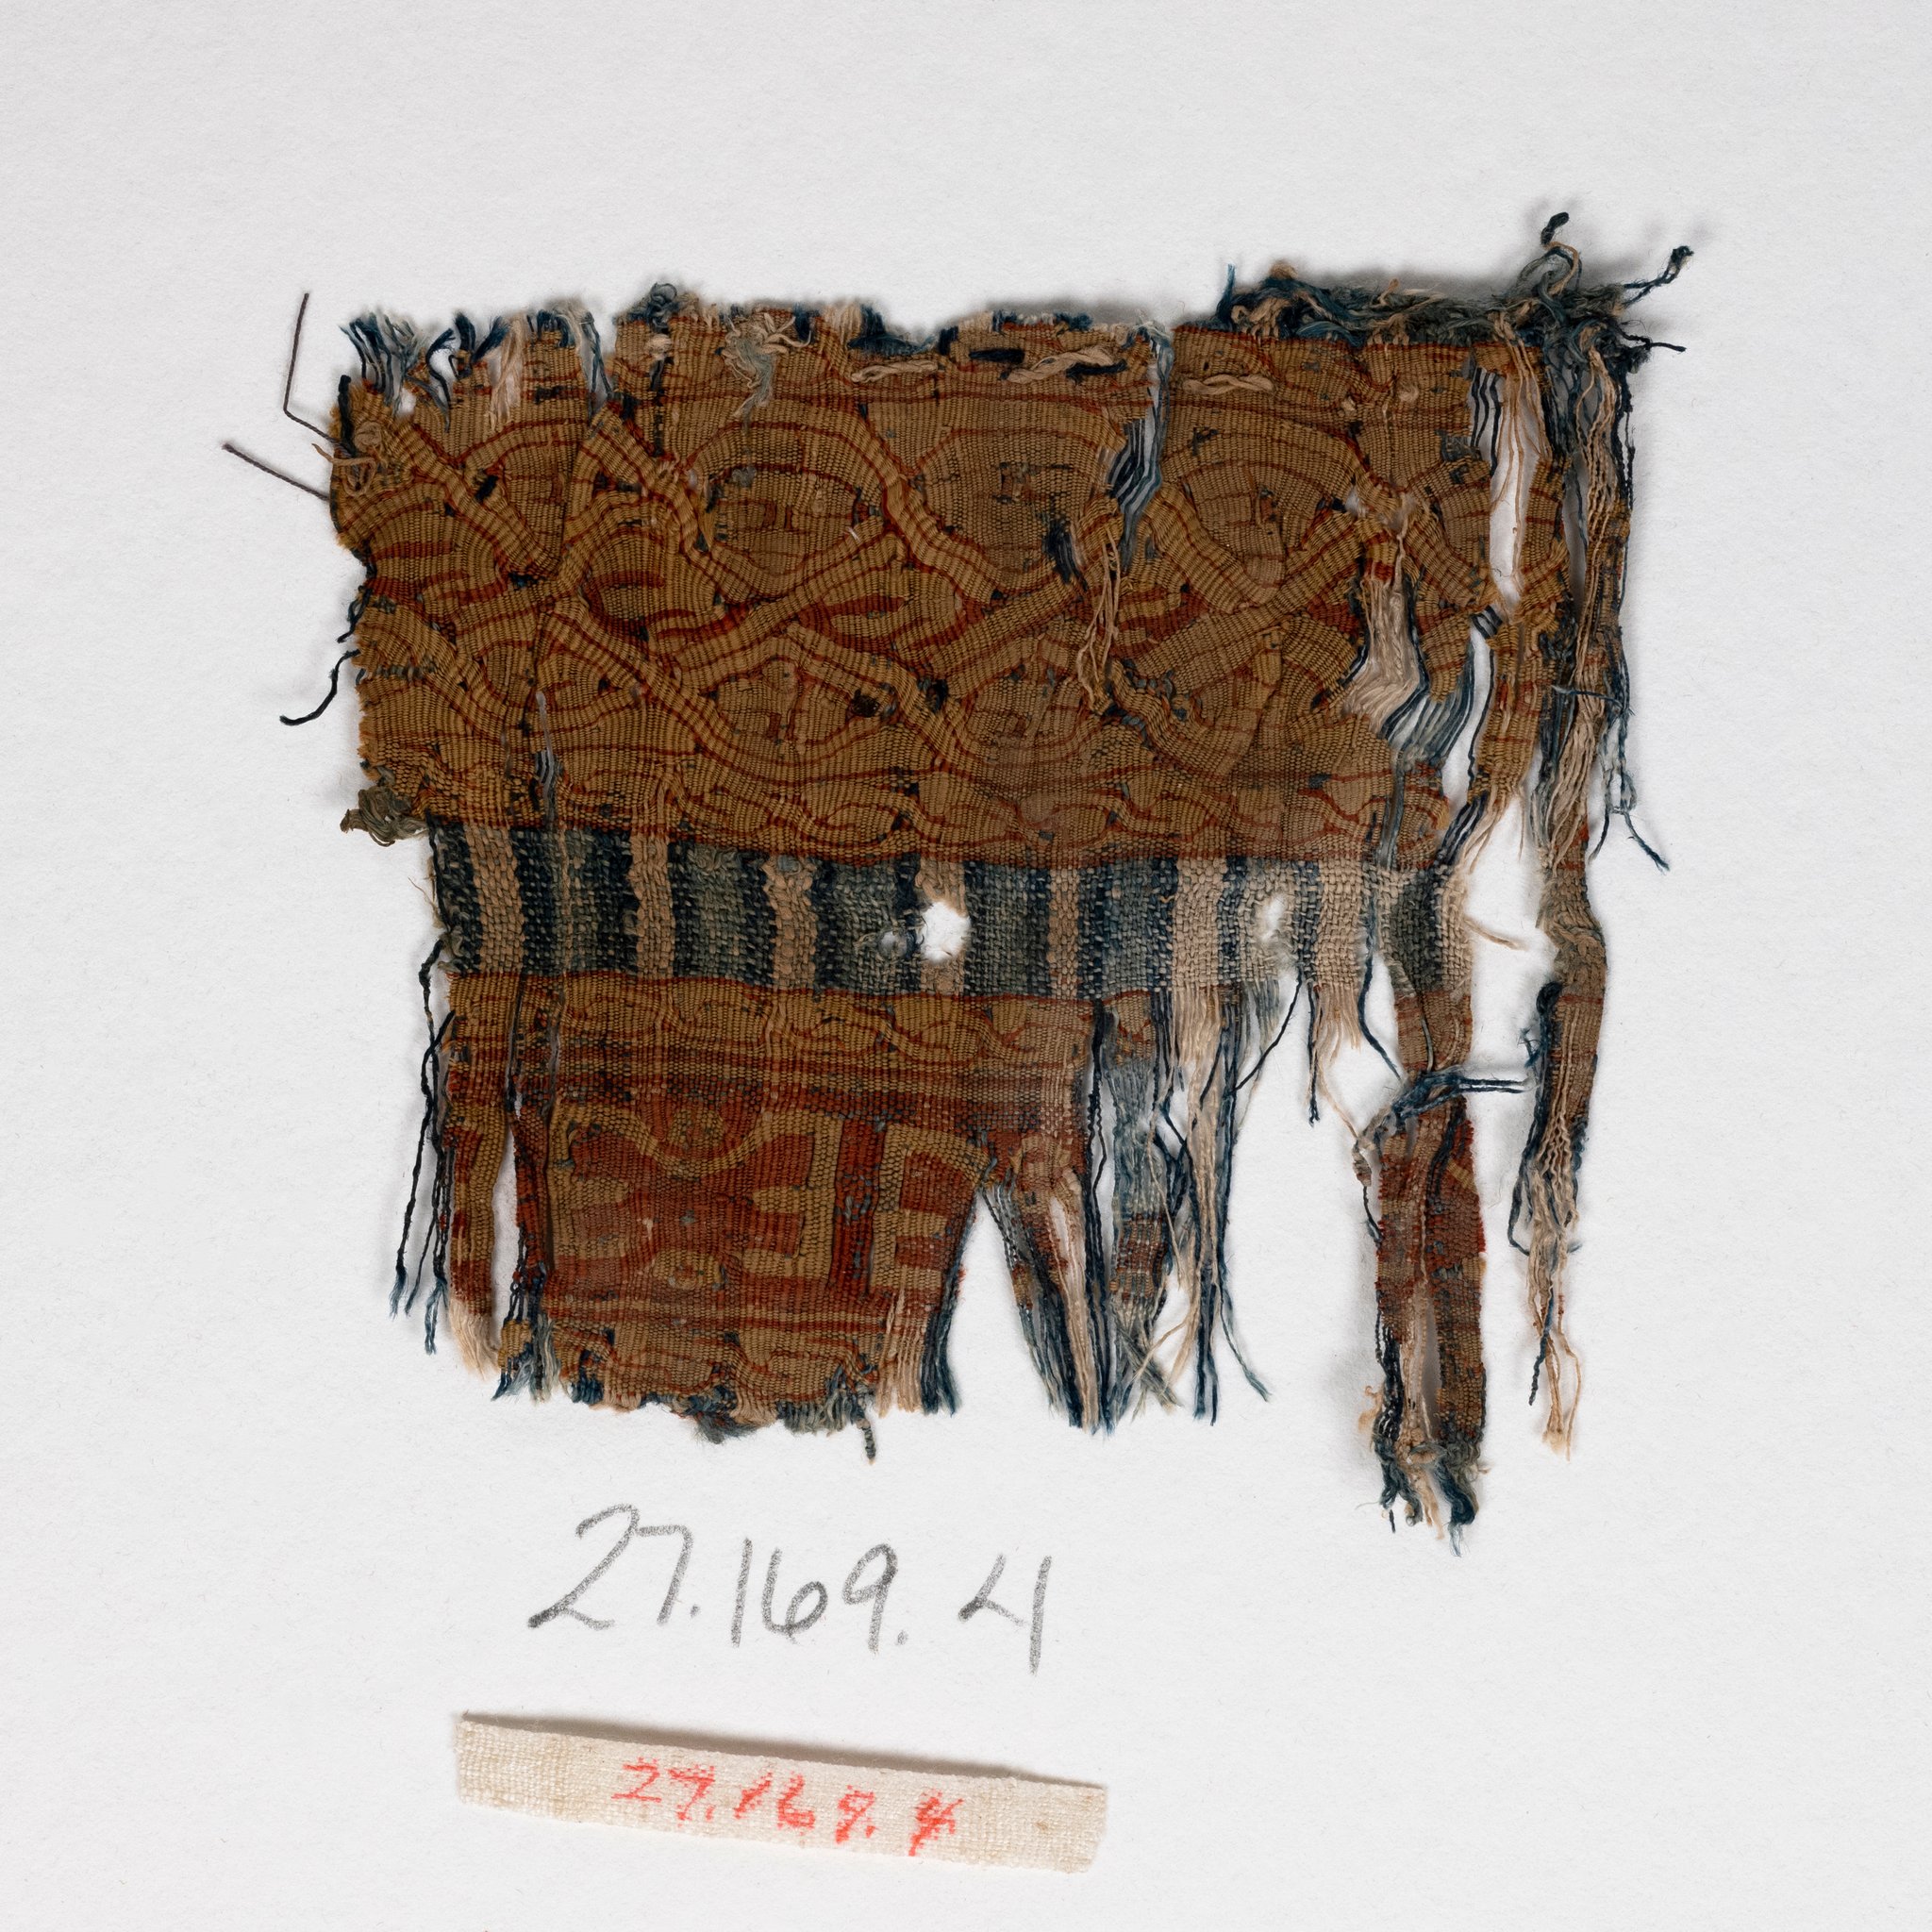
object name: textile fragment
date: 1001-1200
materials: linen, silk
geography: egypt